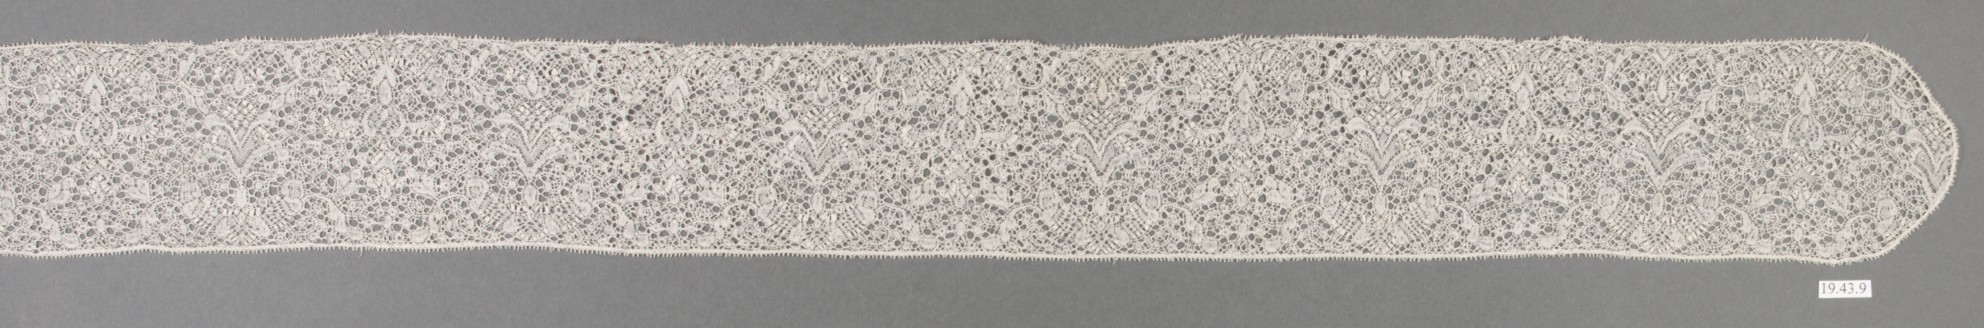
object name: barbe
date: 1701-1800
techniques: lace